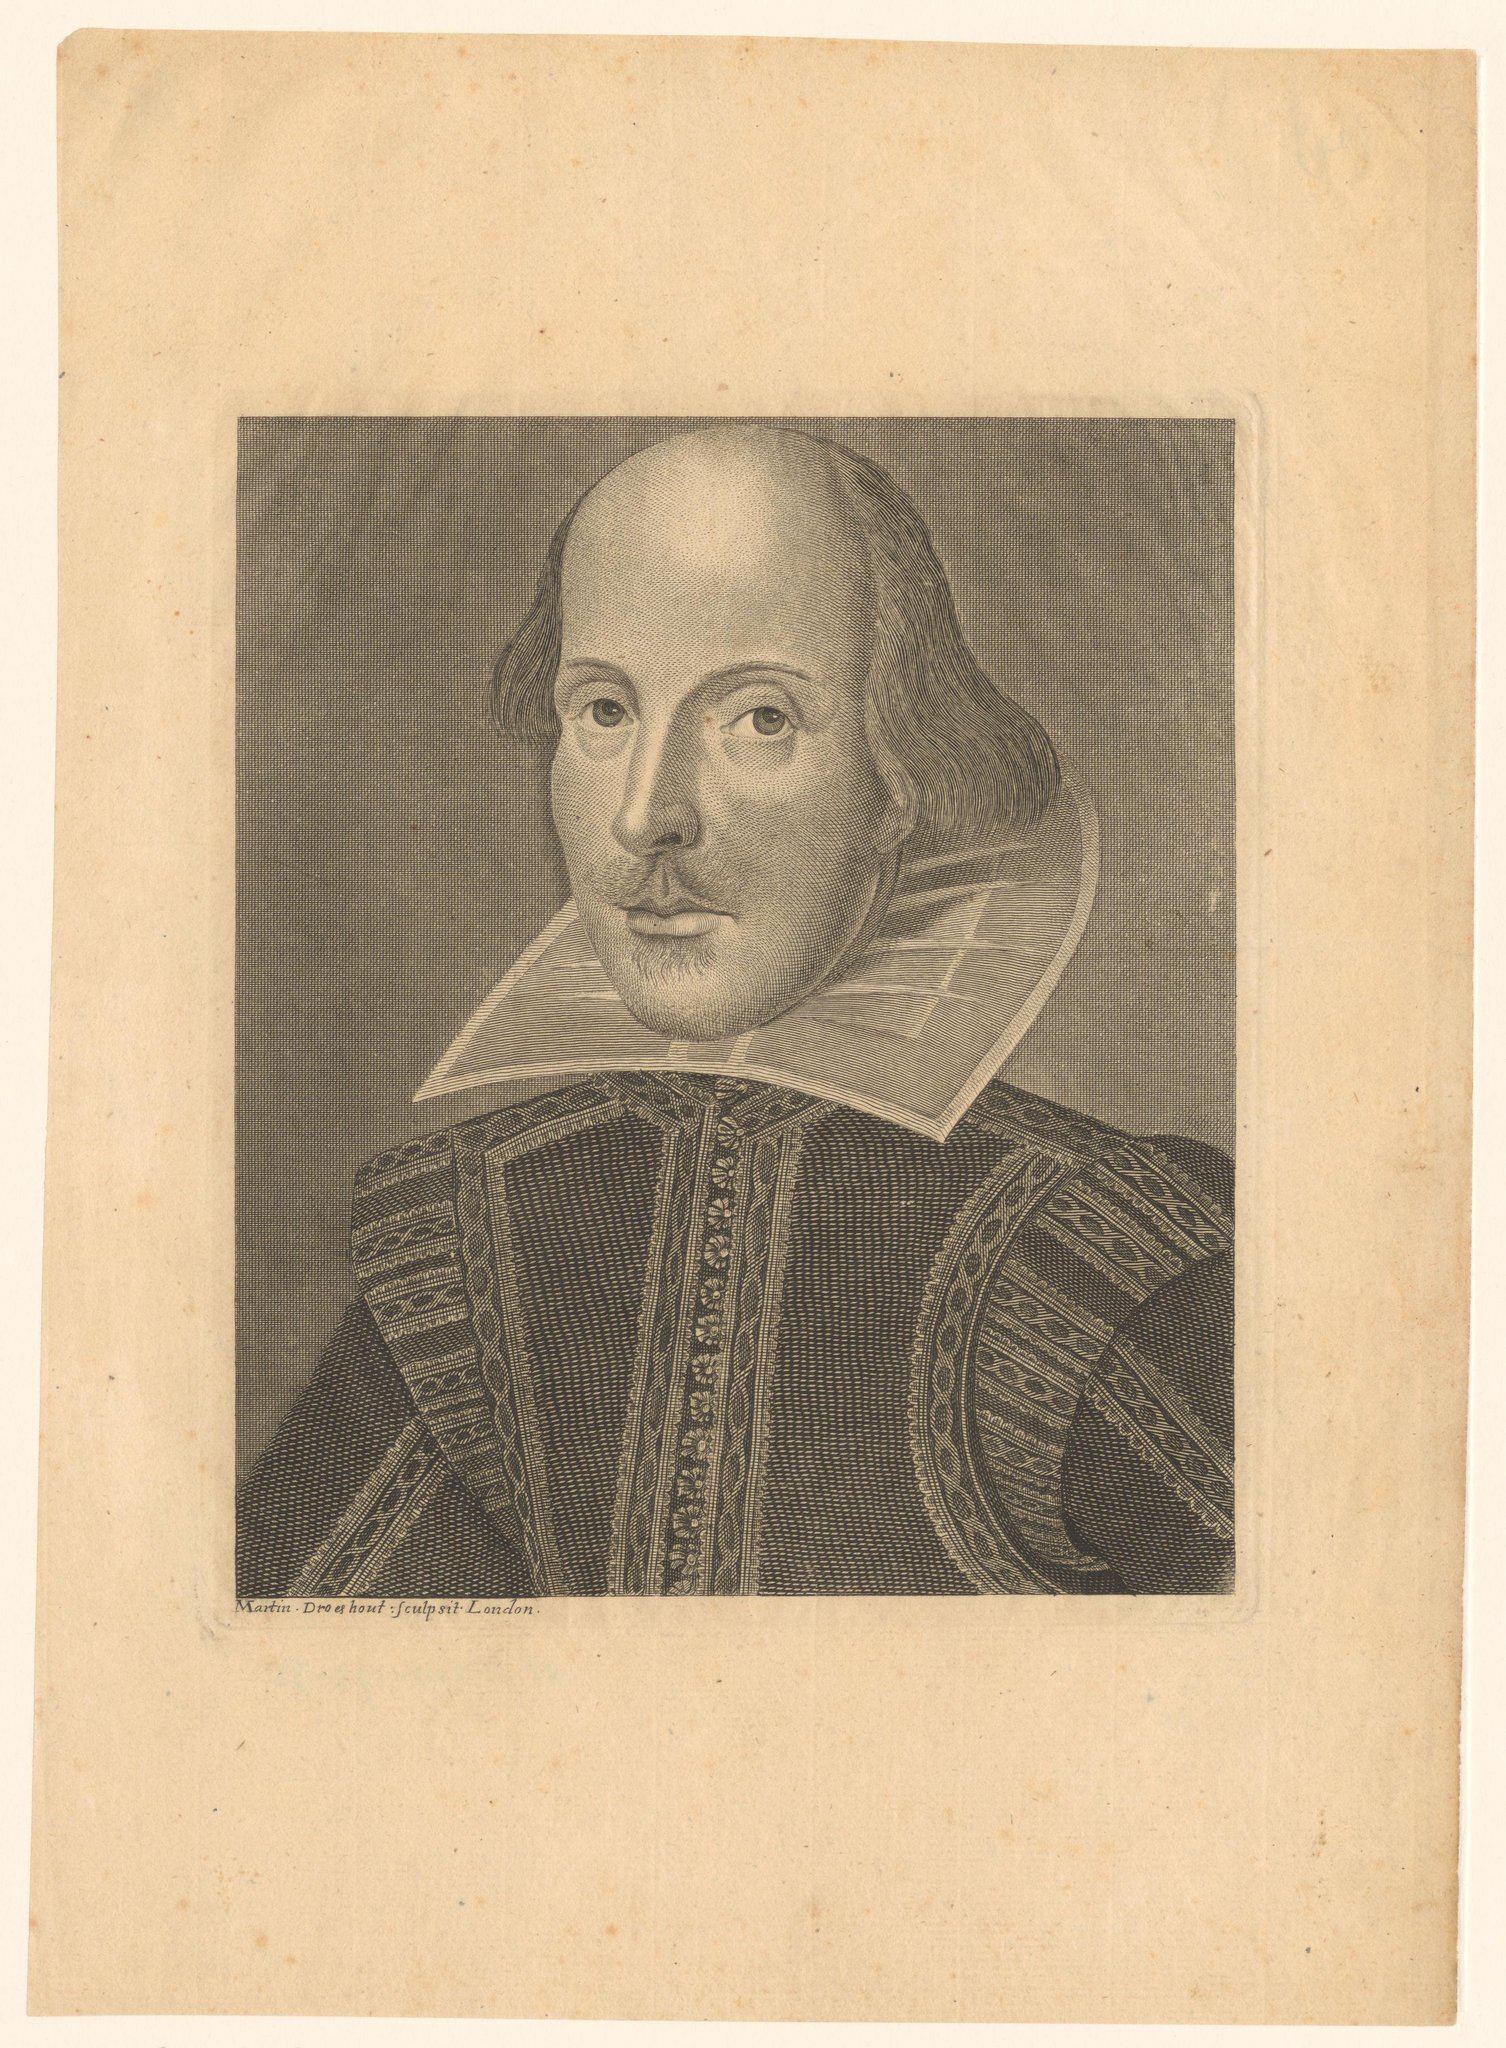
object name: print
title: Portret van William Shakespeare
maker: martin droeshout (ii)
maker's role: print maker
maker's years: 1601-1650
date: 1623-1639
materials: paper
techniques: engraving, etching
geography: london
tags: william shakespeare, historical persons, portrait of a writer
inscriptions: collector's mark: Lugt 2760, collector's mark: Lugt 2228